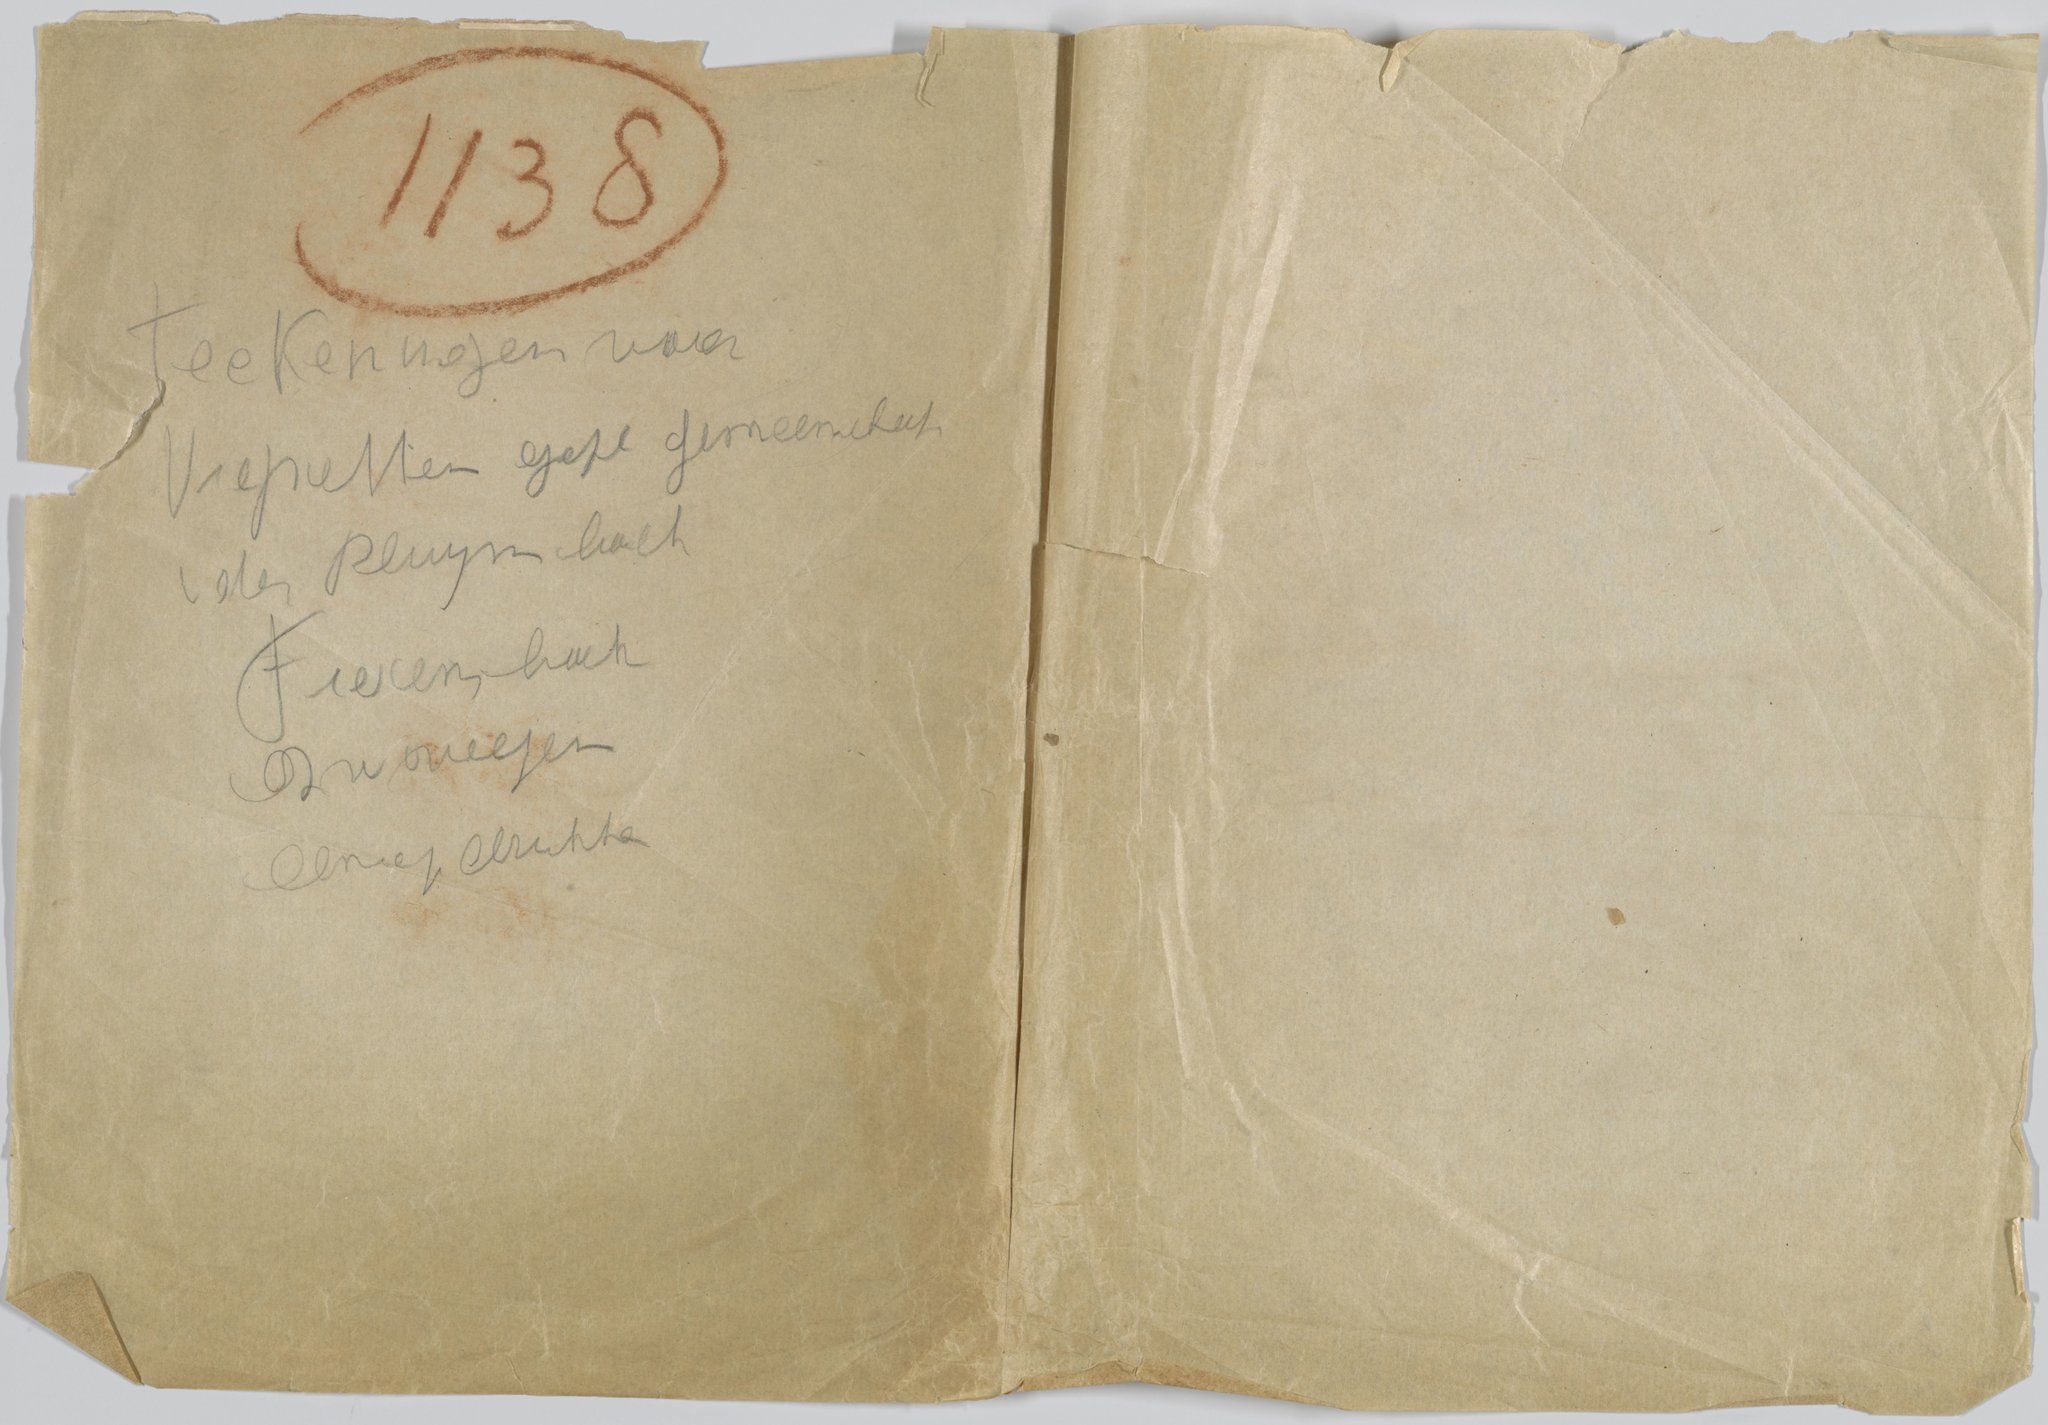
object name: drawing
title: Venus Vignet voor boek 'L'art Hollandais contemporain' van Paul Fierens; calqueerpapier gevouwen omslagblad voor vignetten (DLC)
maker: leo gestel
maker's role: draughtsman, print maker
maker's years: 1881-1941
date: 1932-1933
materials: chalk, pencil, paper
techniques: writing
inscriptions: inscription: ‘Teekeningen voor / Vignetten deze gemeenschap / van der Pluym boek Fierens boek ... / eenige drukken’, number: ‘1138’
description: Gevouwen omslagblad van calqueerpapier voor vignetten.: Venus Vignet voor boek 'L'art Hollandais contemporain' van Paul Fierens.